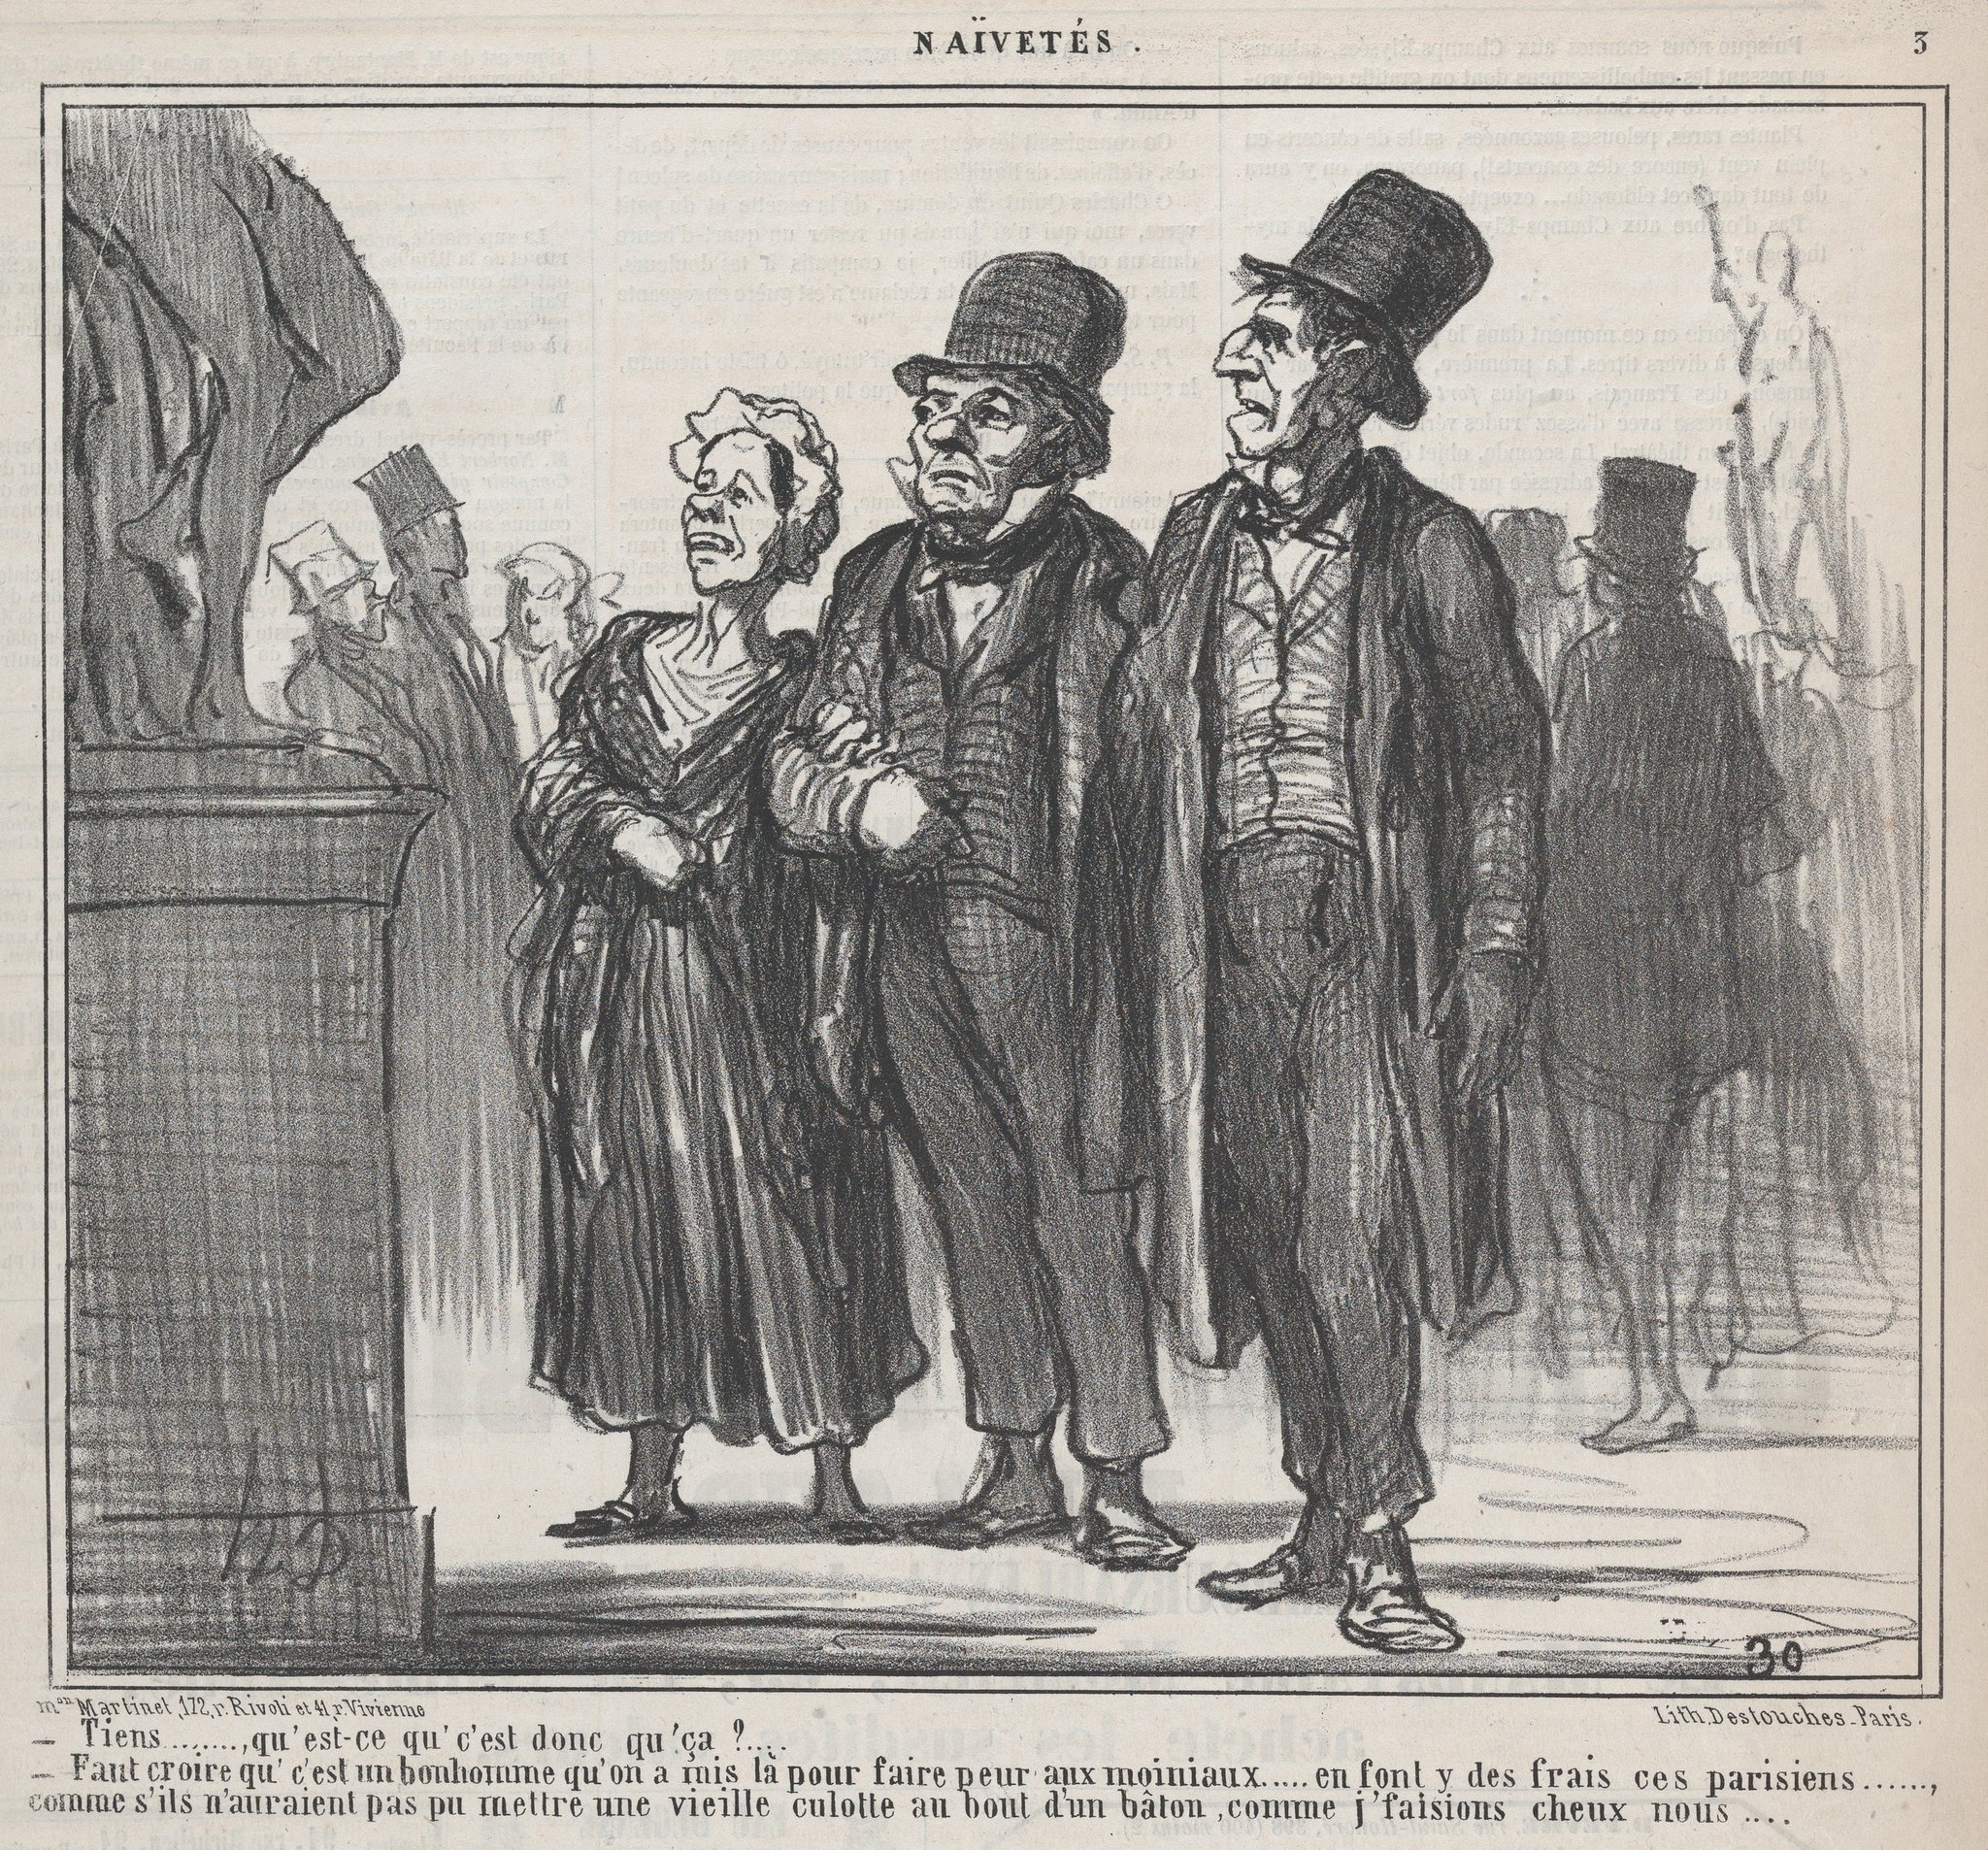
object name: print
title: Tiens..., qu' est-ce qu' c'est donc qu' ça?..., from Naïvetés, published in Le Charivari, April 15, 1859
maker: honoré daumier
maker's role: artist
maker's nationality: french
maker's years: 1808-1879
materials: paper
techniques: lithograph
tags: men,women